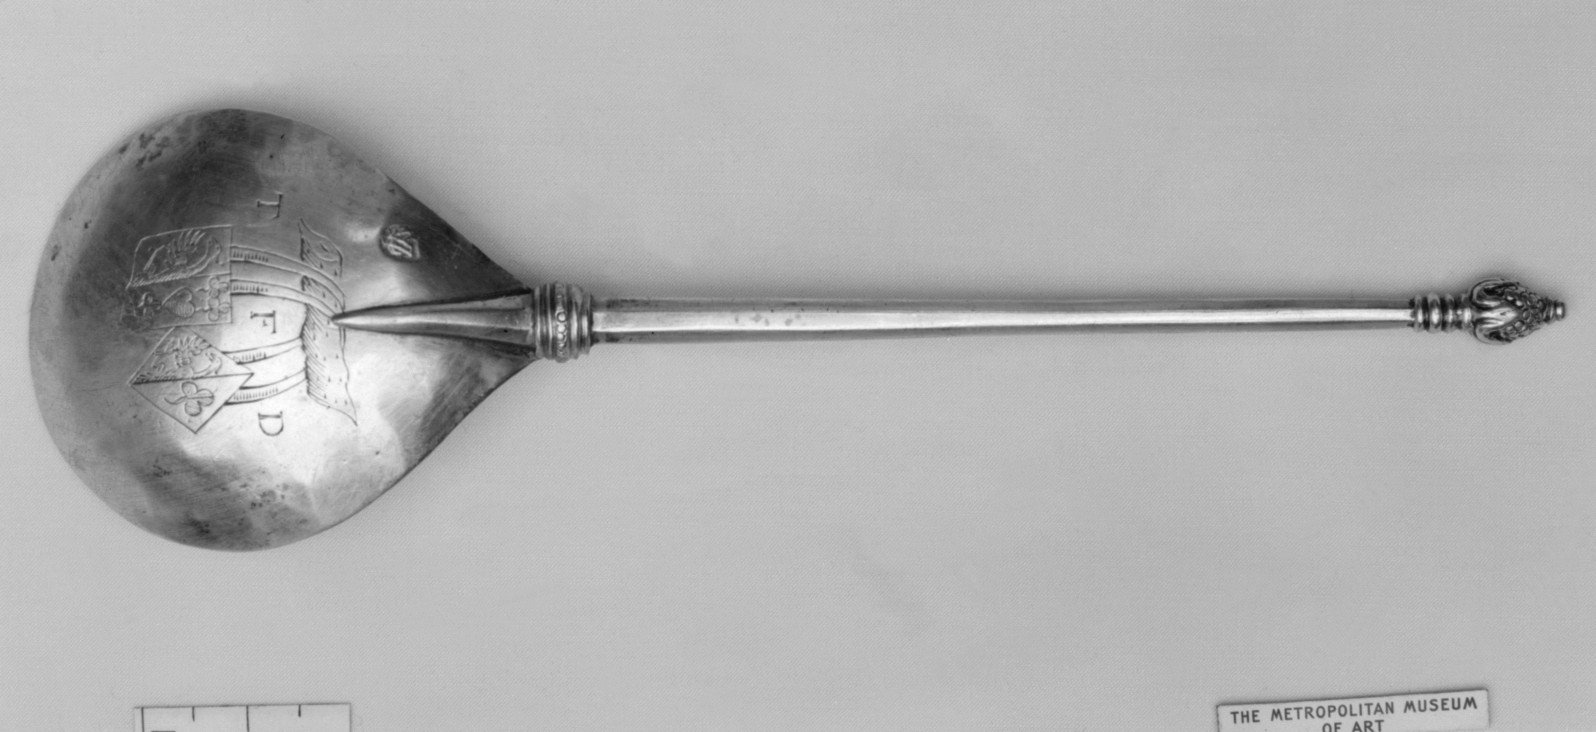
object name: spoon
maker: wilke doncker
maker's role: maker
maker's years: 1634-1636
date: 1634-1636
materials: silver